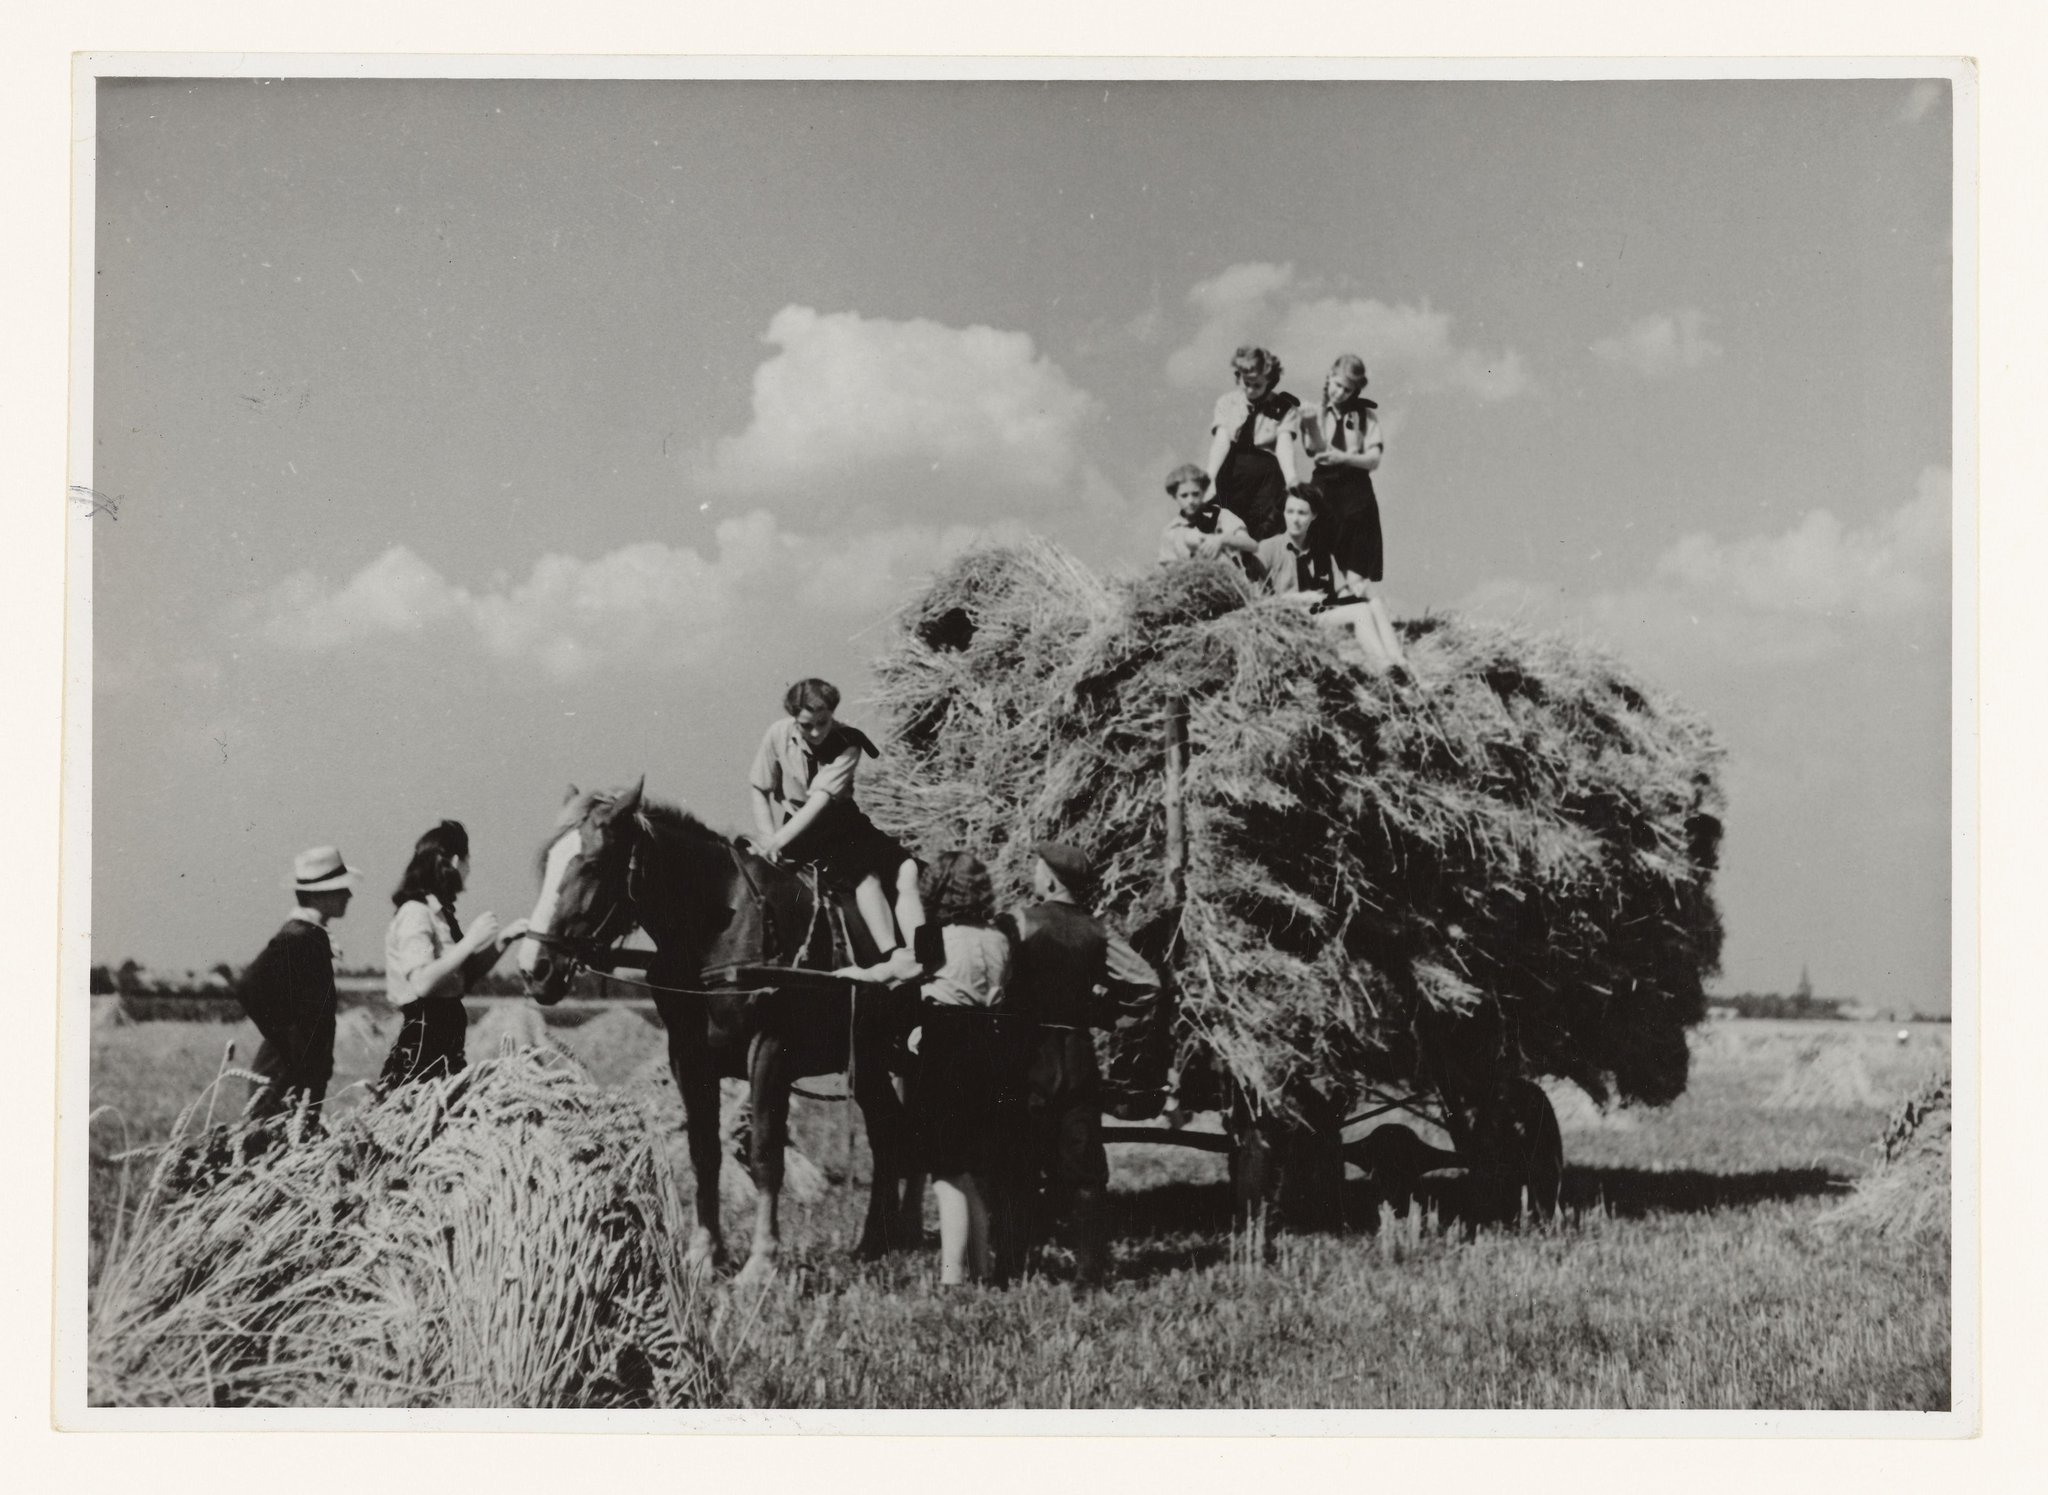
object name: photograph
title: Jeugdstorm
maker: j.h. hasewinkel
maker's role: fotograaf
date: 1908-1943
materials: photographic support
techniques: gelatin silver print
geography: noordoostpolder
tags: military training, hay-wagon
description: Een groep meisjes van de Jeugdstorm helpt boeren met het hooien in de Noordoostpolder, in uniform. Vier meisjes zitten op de hooibalen op een kar, eentje zit op het paard. Twee anderen staan naast de twee boeren.